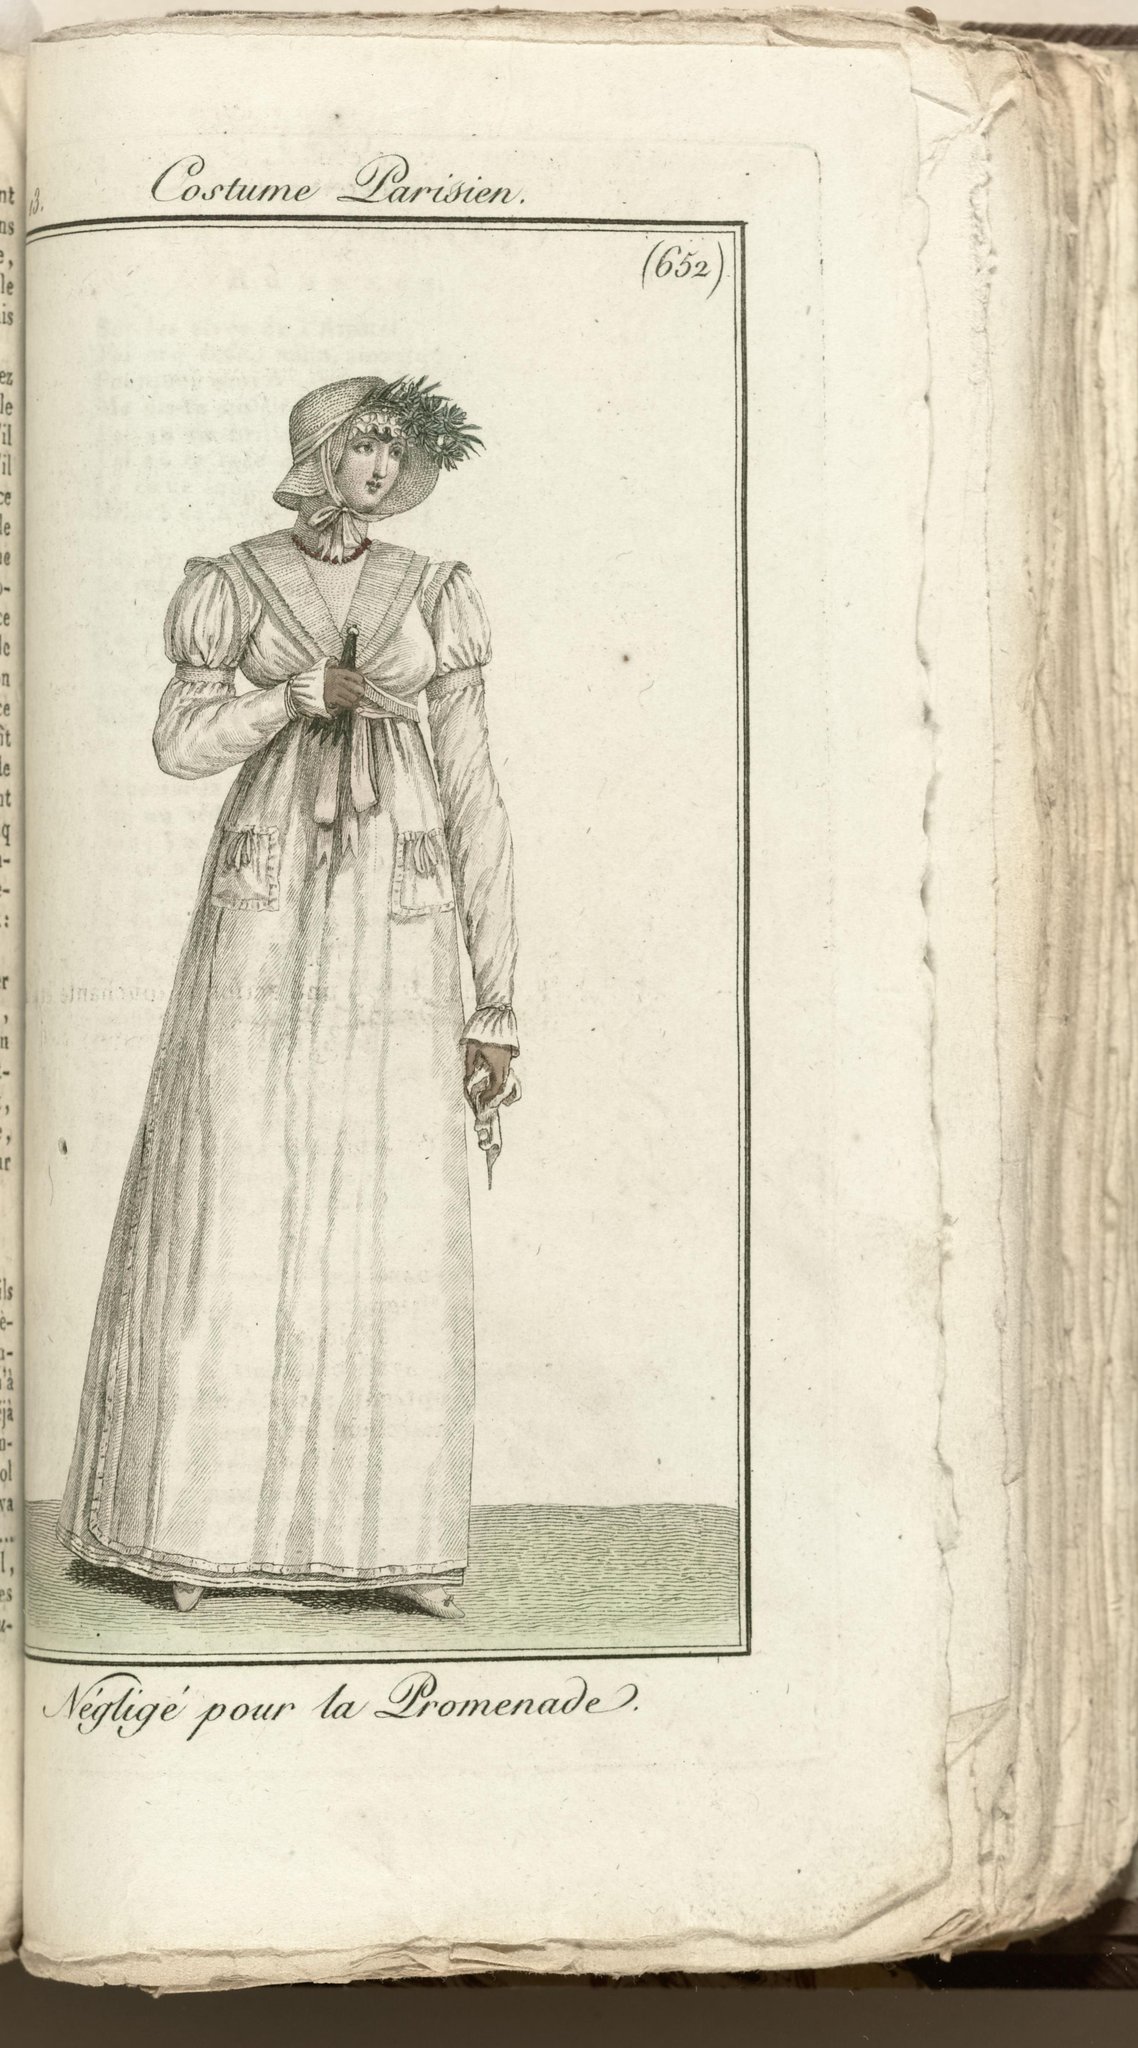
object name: fashion print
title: Journal des Dames et des Modes, Costume Parisien, 1805, An 13 (652) Négligé pour la Promenade.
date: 1805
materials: paper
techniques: engraving, hand coloring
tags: handkerchief (+ women's clothes), dress, gown: walking dress (+ women's clothes), head-gear (straw hat) (+ women's clothes), head-gear (bonnet) (+ women's clothes), fashion plates, fan (+ women's clothes)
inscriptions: title: ‘Négligé pour la Promenade.’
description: Vrouw in wandelkostuum: witte japon met fichu en lange mouwen, twee kleine zakjes op heuphoogte. Luifelhoed over een bonnet. Zakdoek in de ene, kleine waaier in de andere hand. Platte schoenen.